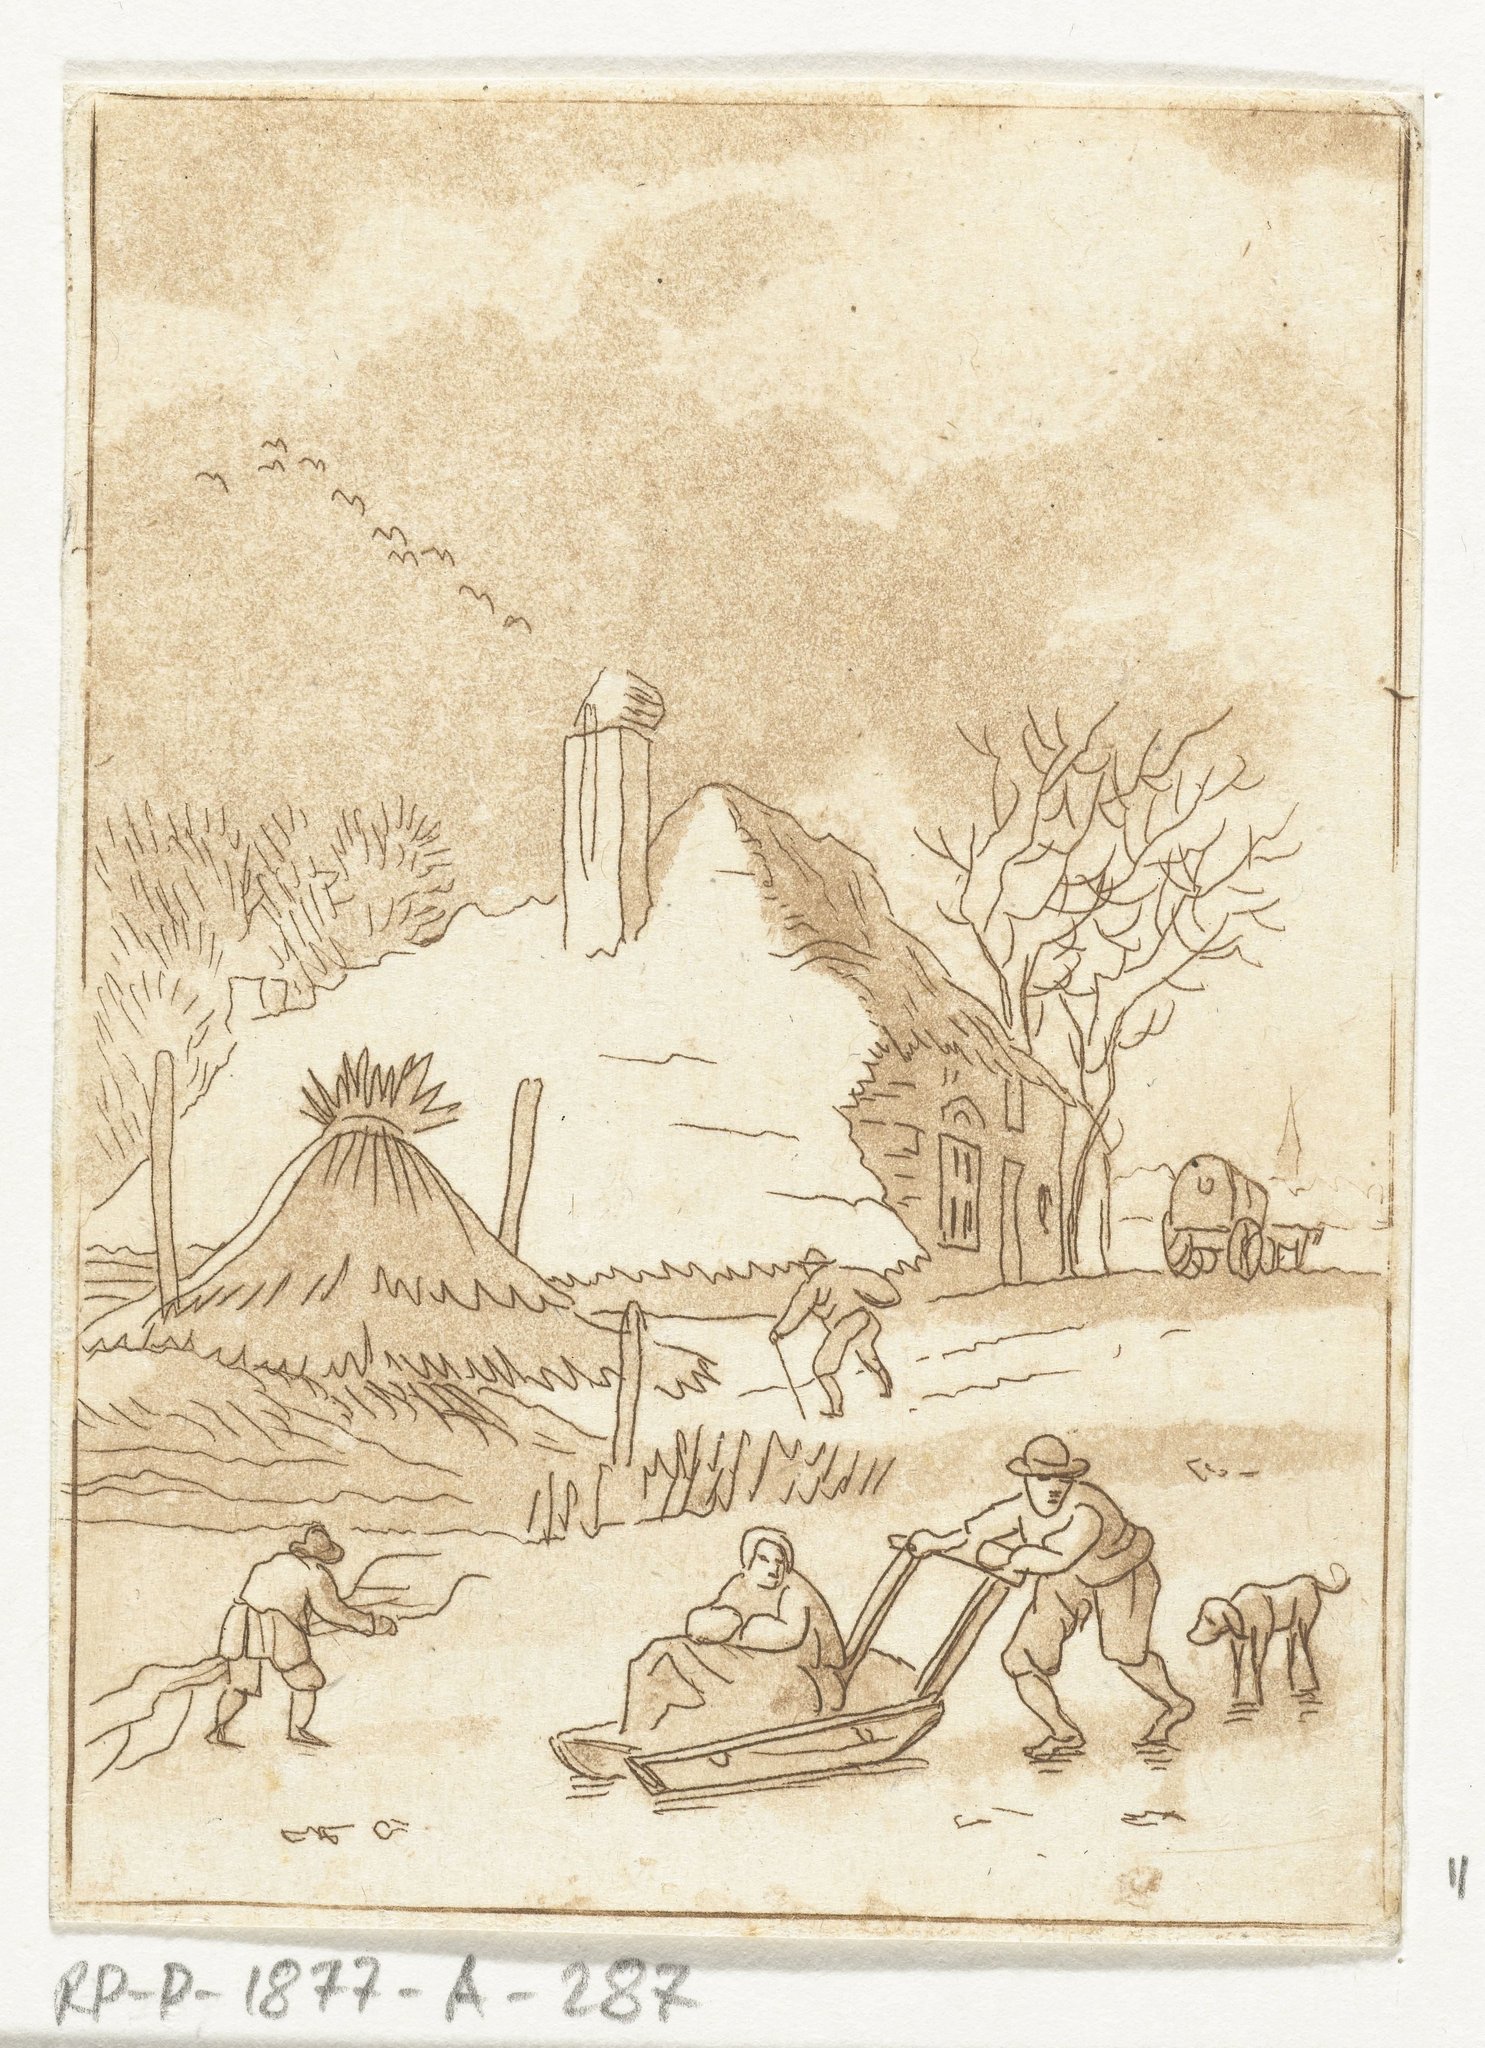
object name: print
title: Winterlandschap met ijsvermaak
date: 1778-1838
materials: paper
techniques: aquatint, etching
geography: netherlands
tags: winter sports, dog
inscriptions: collector's mark: Lugt 2228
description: Winterlandschap. Op een bevroren rivier duwt een boer een slede met een vrouw. Achter hem aan loopt een hond. Links loopt een jongen die takken vergaart heeft. Op de achtergrond een huis met een kar ervoor.